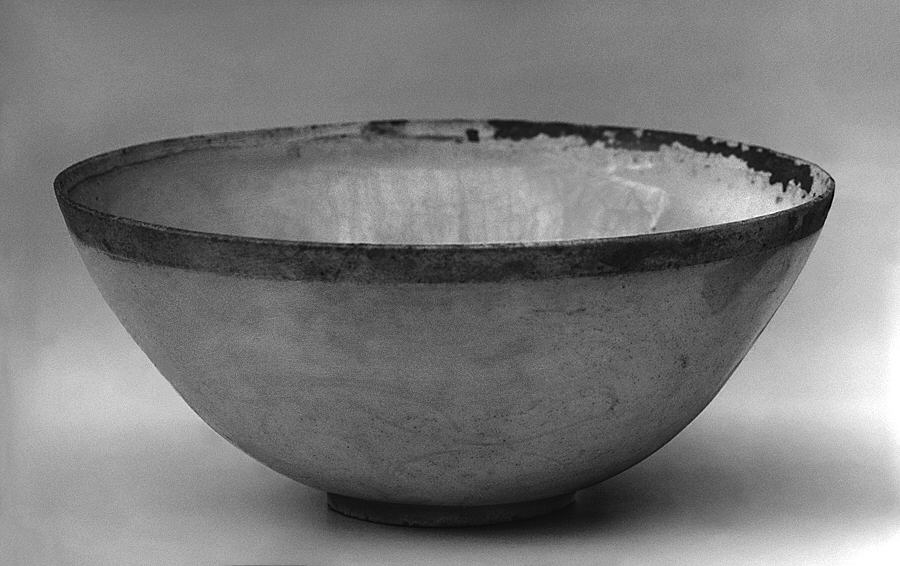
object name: bowl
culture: chinese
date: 960-1279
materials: glaze